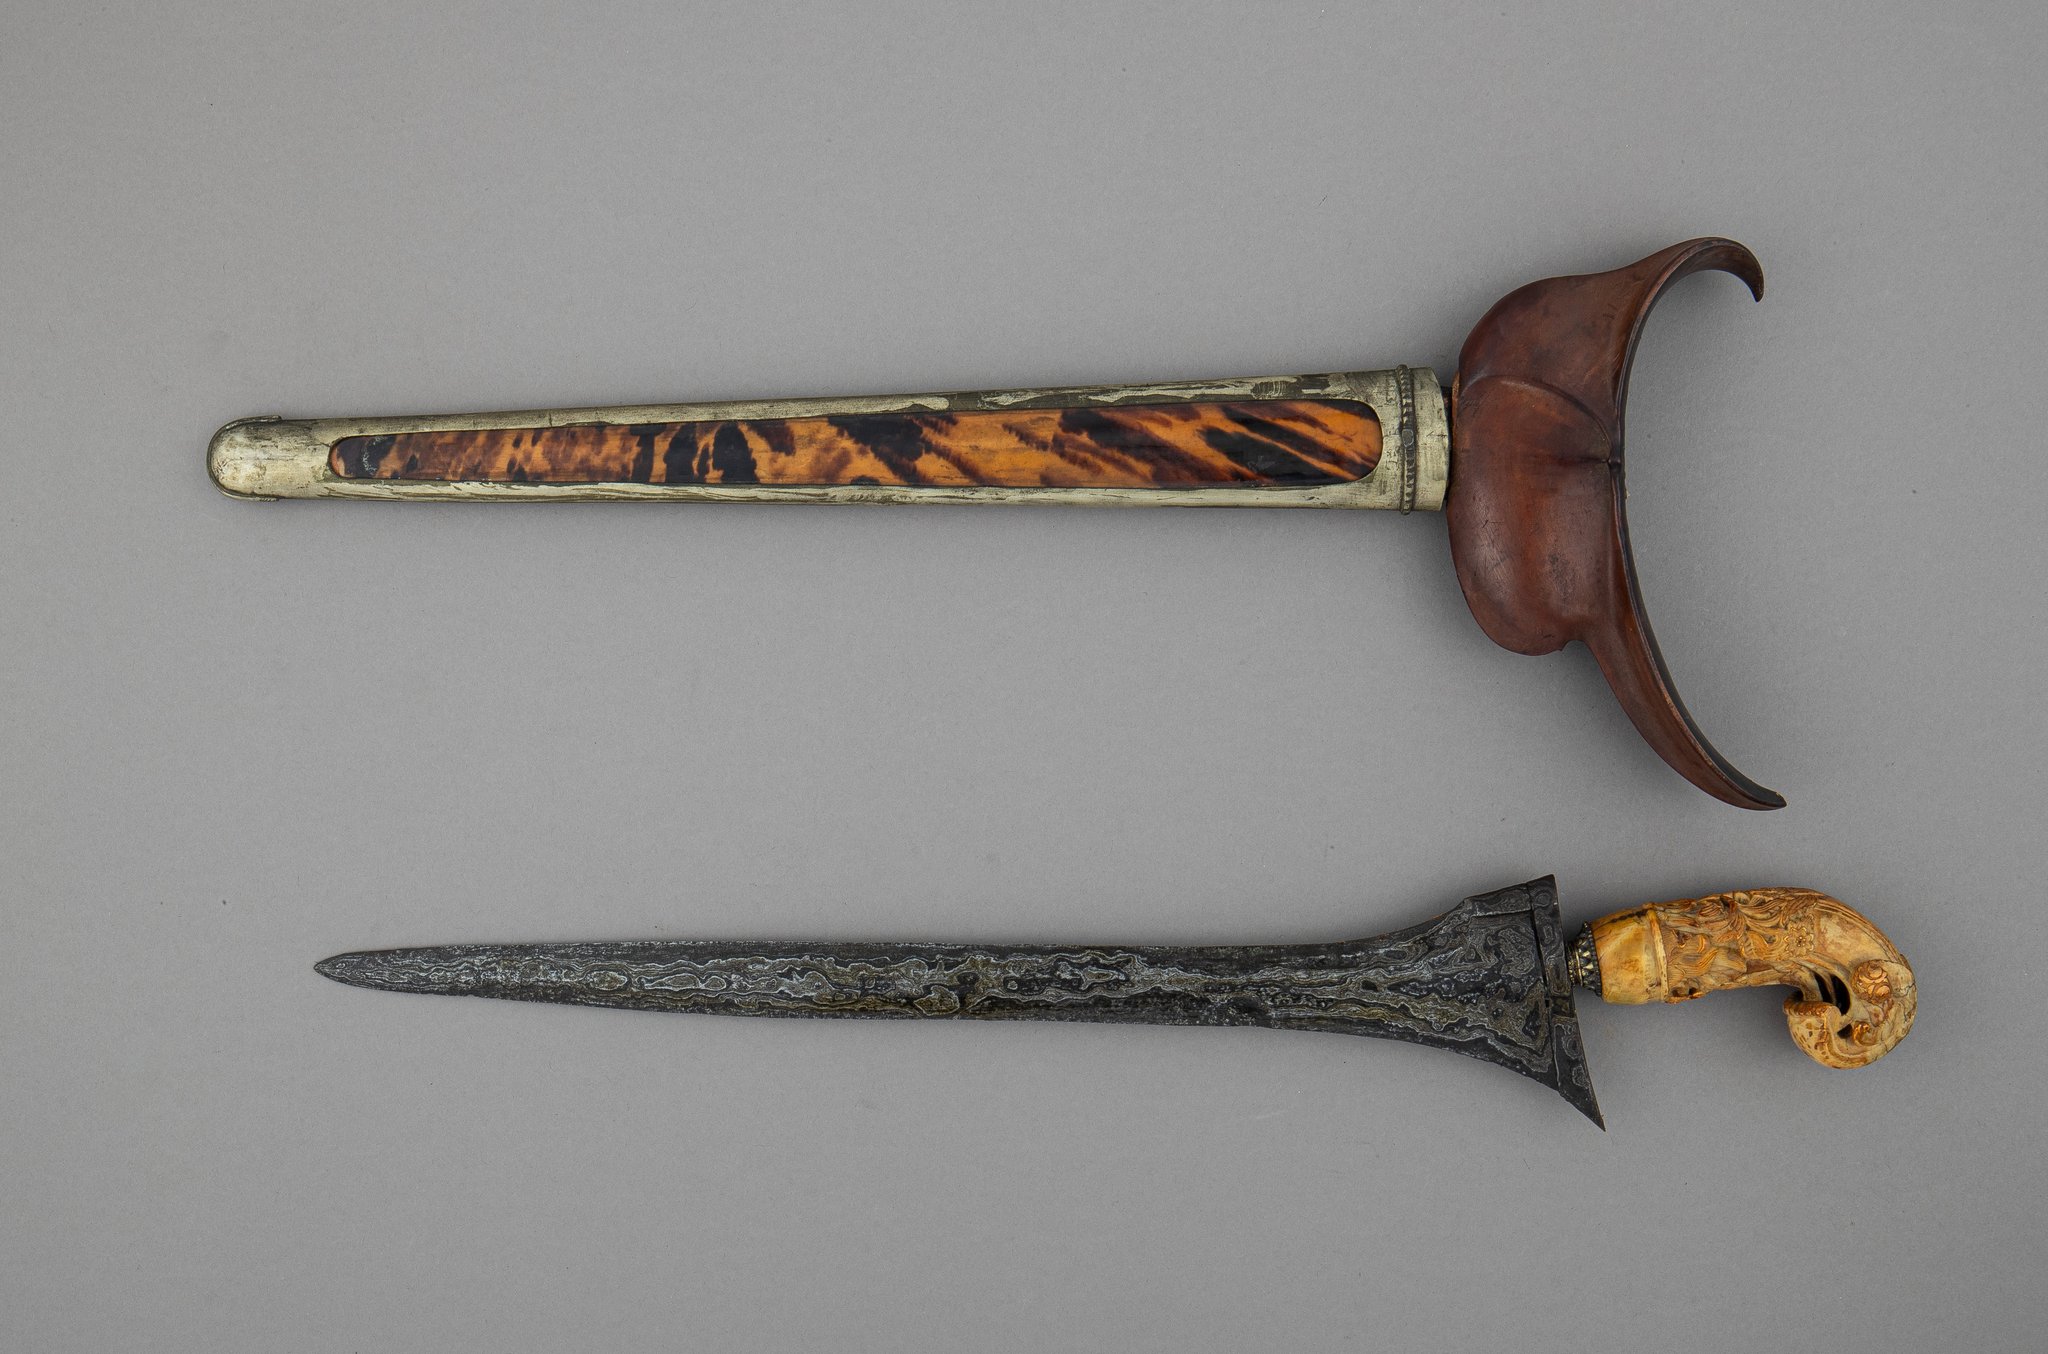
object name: kris with sheath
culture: madurese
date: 1501-1900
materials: brass, ivory, steel, shell, wood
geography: indonesia